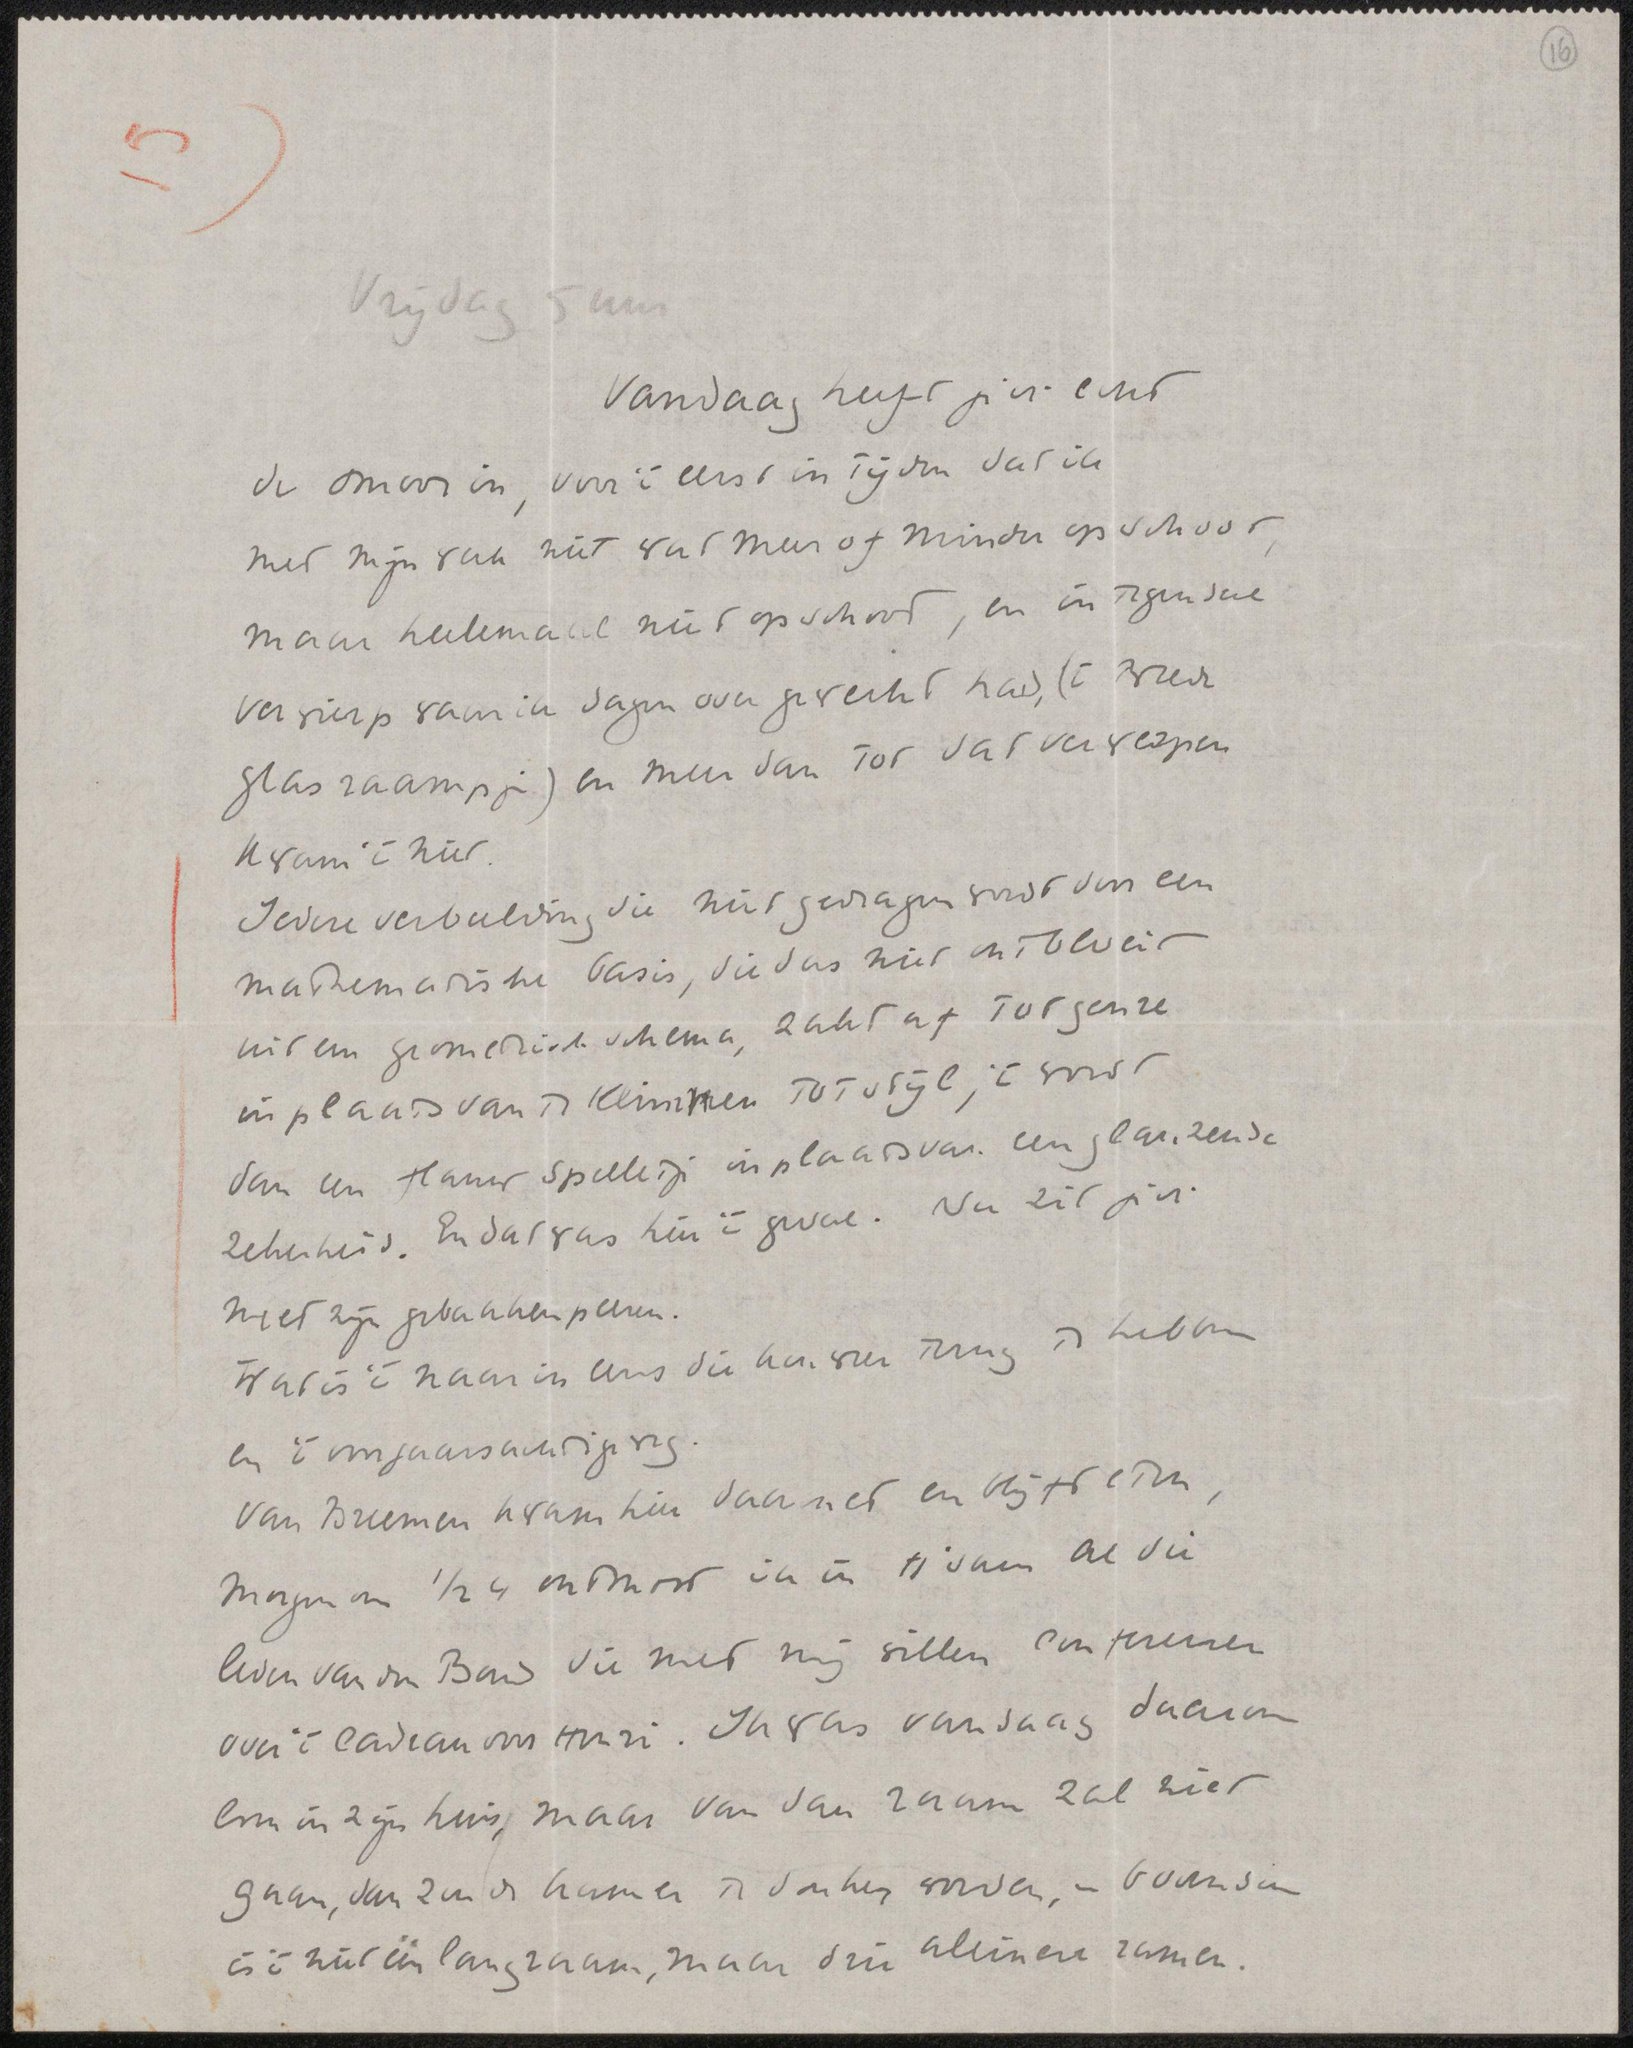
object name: letter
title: Brief aan Ina van Eibergen Santhagens-Waller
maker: richard nicolaüs roland holst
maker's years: 1868-1938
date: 1878-1938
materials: ink, paper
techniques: pen, writing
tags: haarlem, amsterdam, print maker, ina van eibergen santhagens-waller, passions, emotions, affections, applied arts, arts and crafts; industrial design, historical persons (portraits and scenes from the life)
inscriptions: collector's mark: ‘RPK’